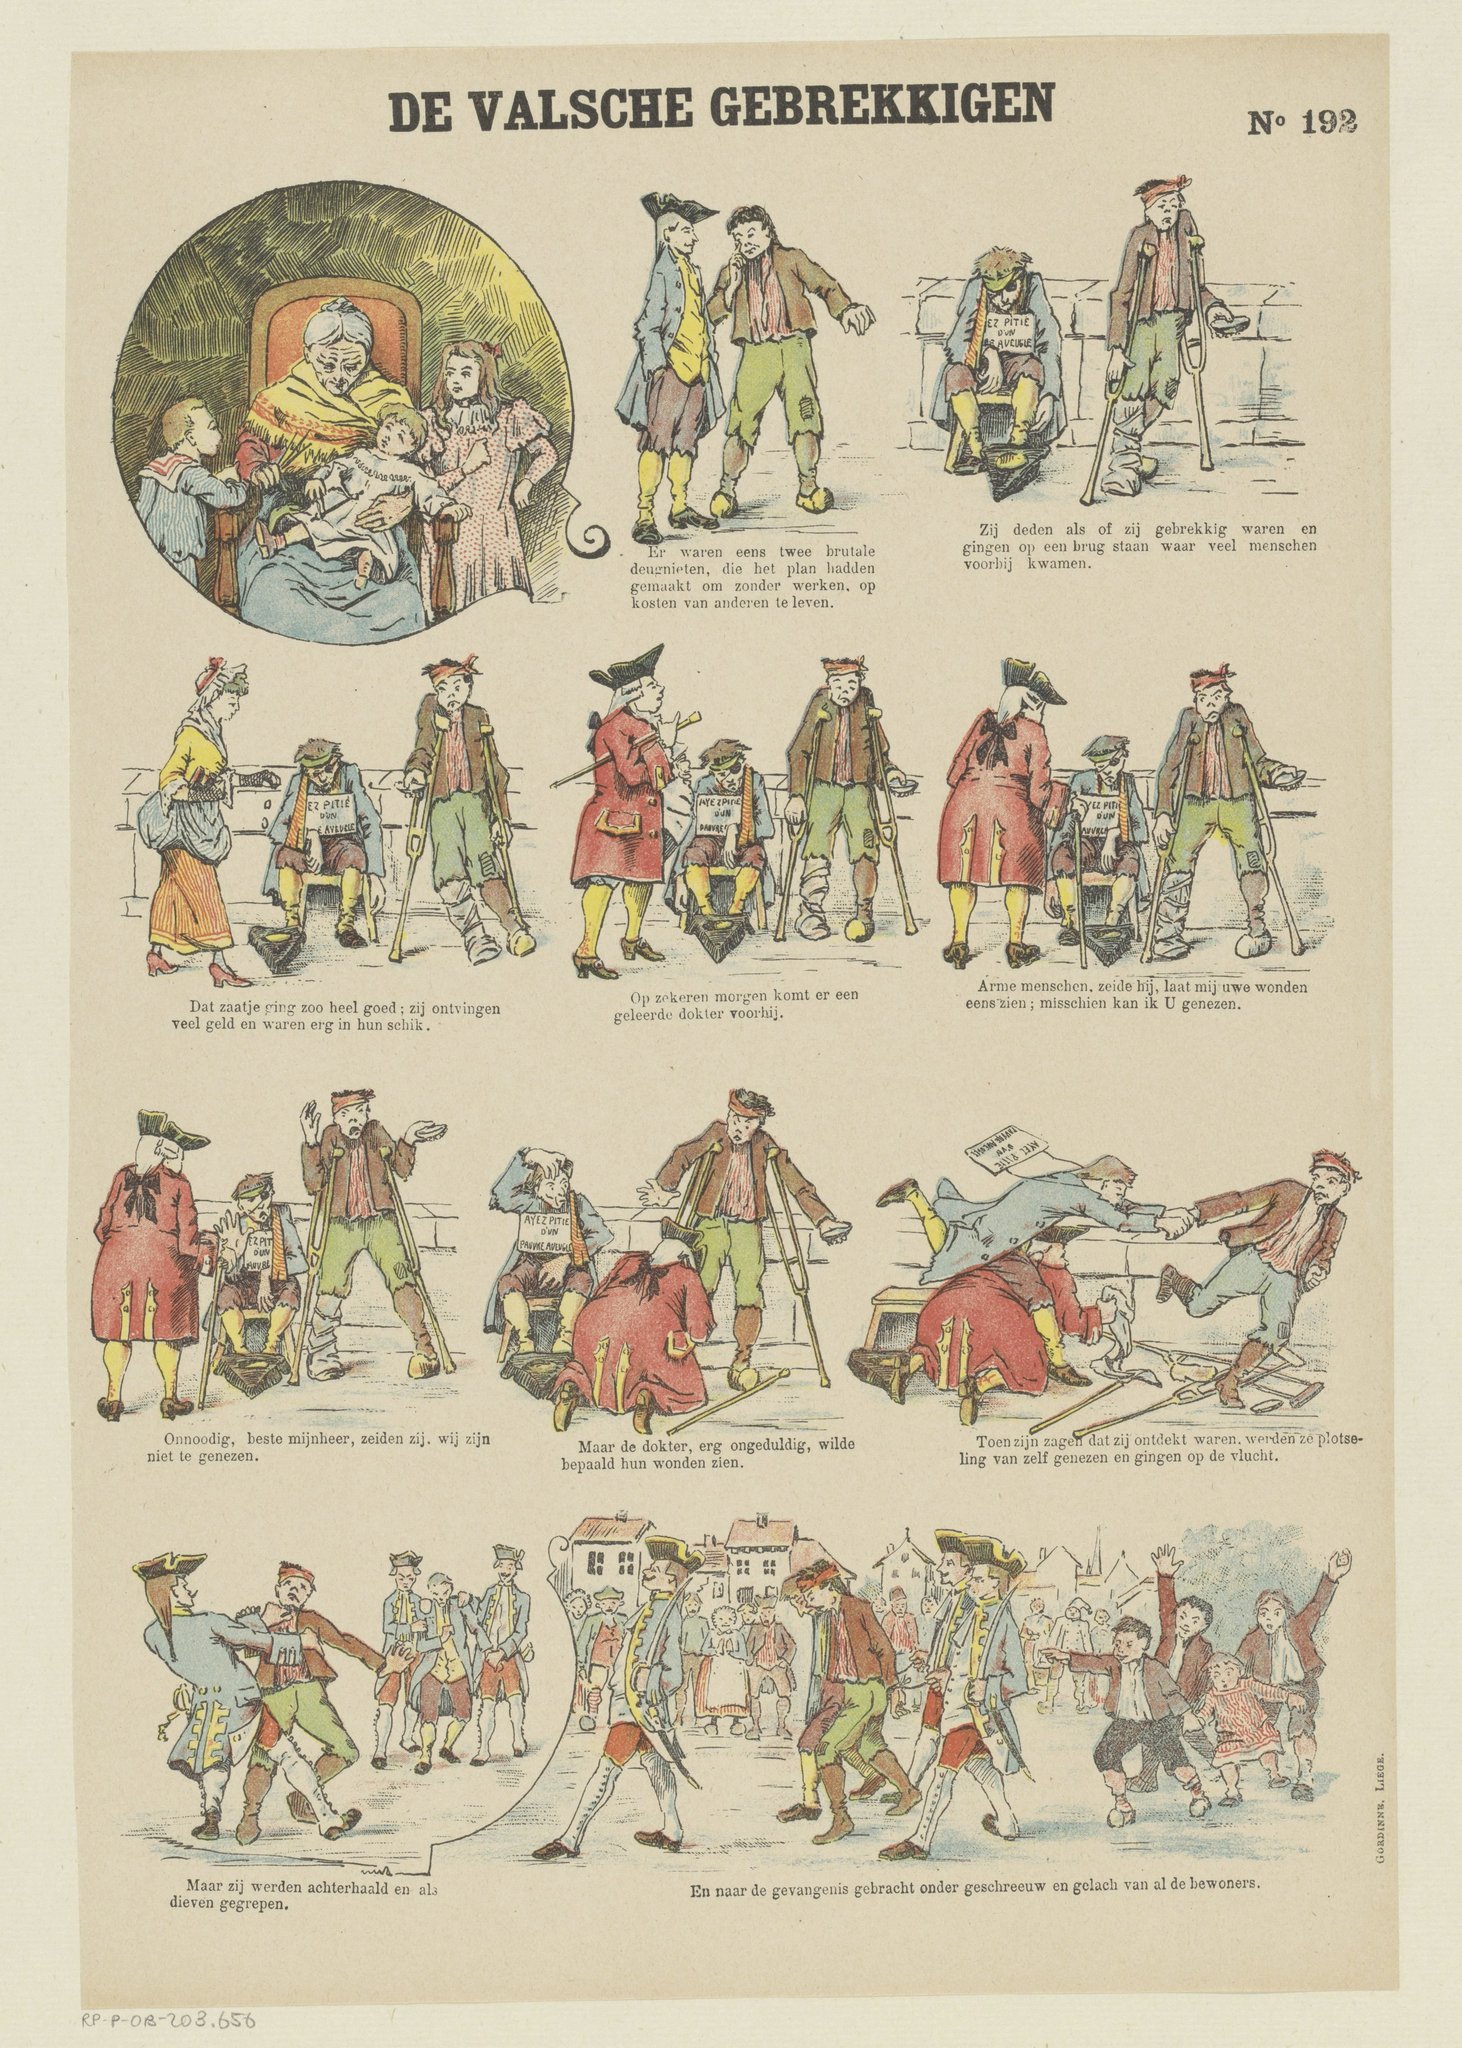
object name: popular print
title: De valsche gebrekkigen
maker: Anonymous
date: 1894-1959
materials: paper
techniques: lithograph, letterpress printing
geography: liège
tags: disabilities, deformations, arrest (of criminal), beggar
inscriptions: collector's mark: Lugt 2760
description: Blad met 11 voorstellingen over twee mannen die doen alsof zij gehandicapt zijn om niet te hoeven werken. Onder elke afbeelding een onderschrift. Genummerd rechtsboven: No 192.